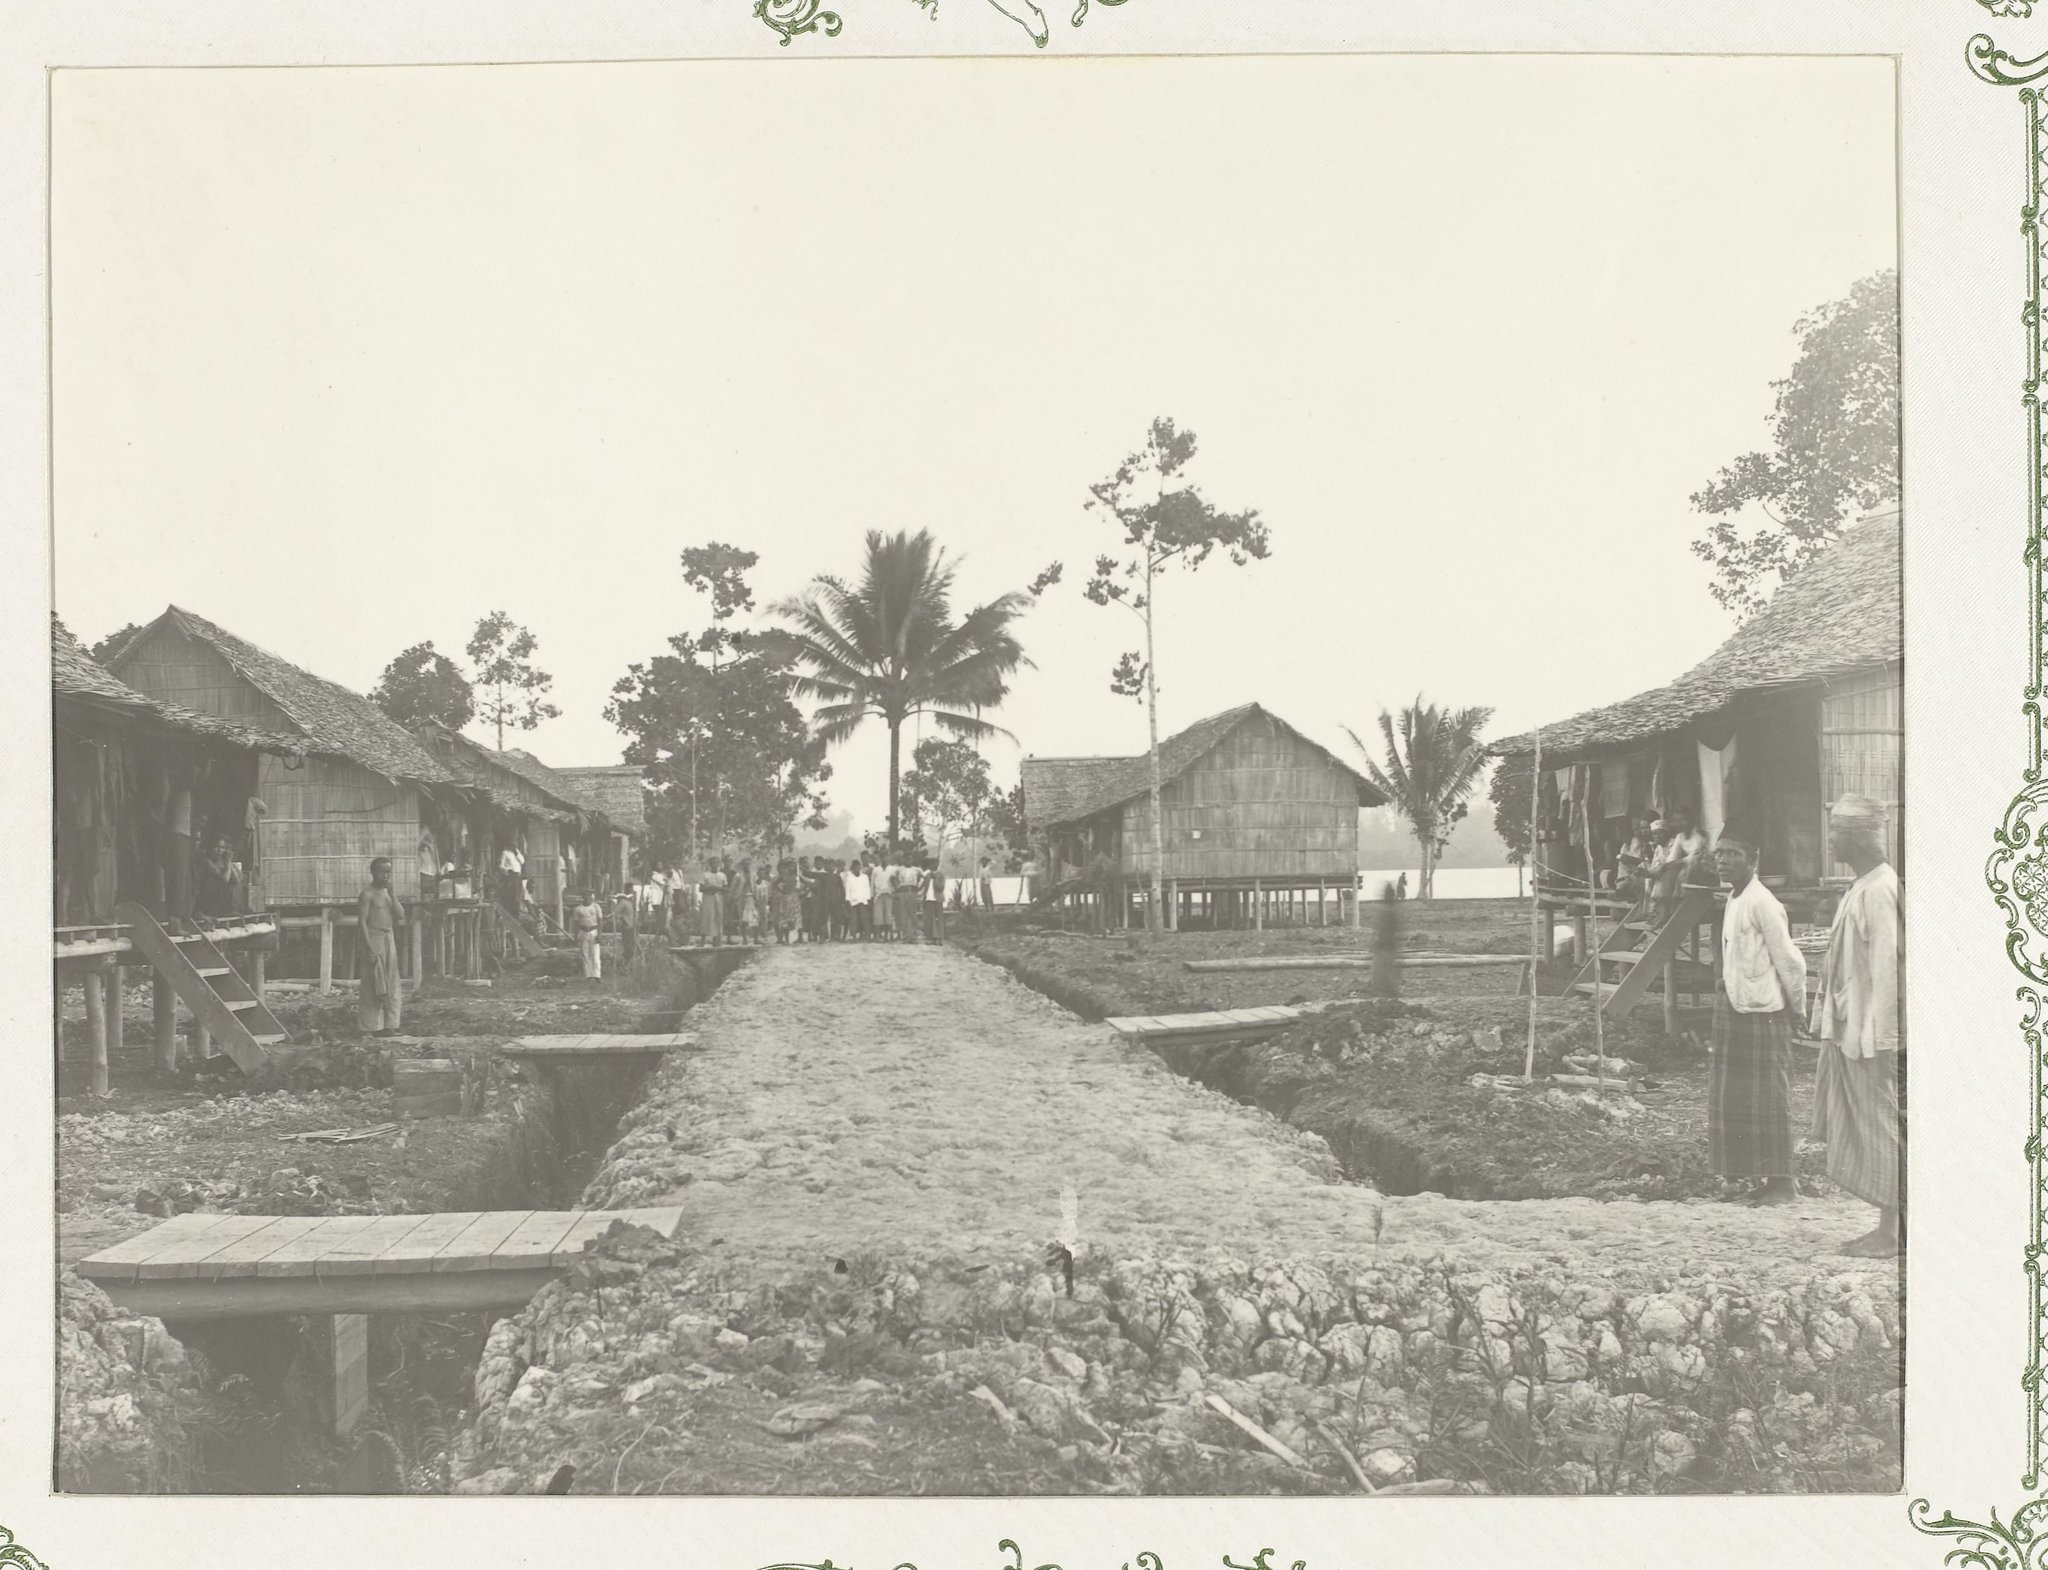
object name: album leaf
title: Dorpsbewoners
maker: Anonymous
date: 1903-1907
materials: paper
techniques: gelatin silver print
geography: kalimantan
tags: public road in village, borneo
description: Gezicht in een dorp met de inwoners staande voor hun huizen. Foto in het fotoalbum over de oliewinning op Borneo door de Koninklijke Nederlandsche Petroleum Maatschappij (KNPM) in de jaren 1903-1907.